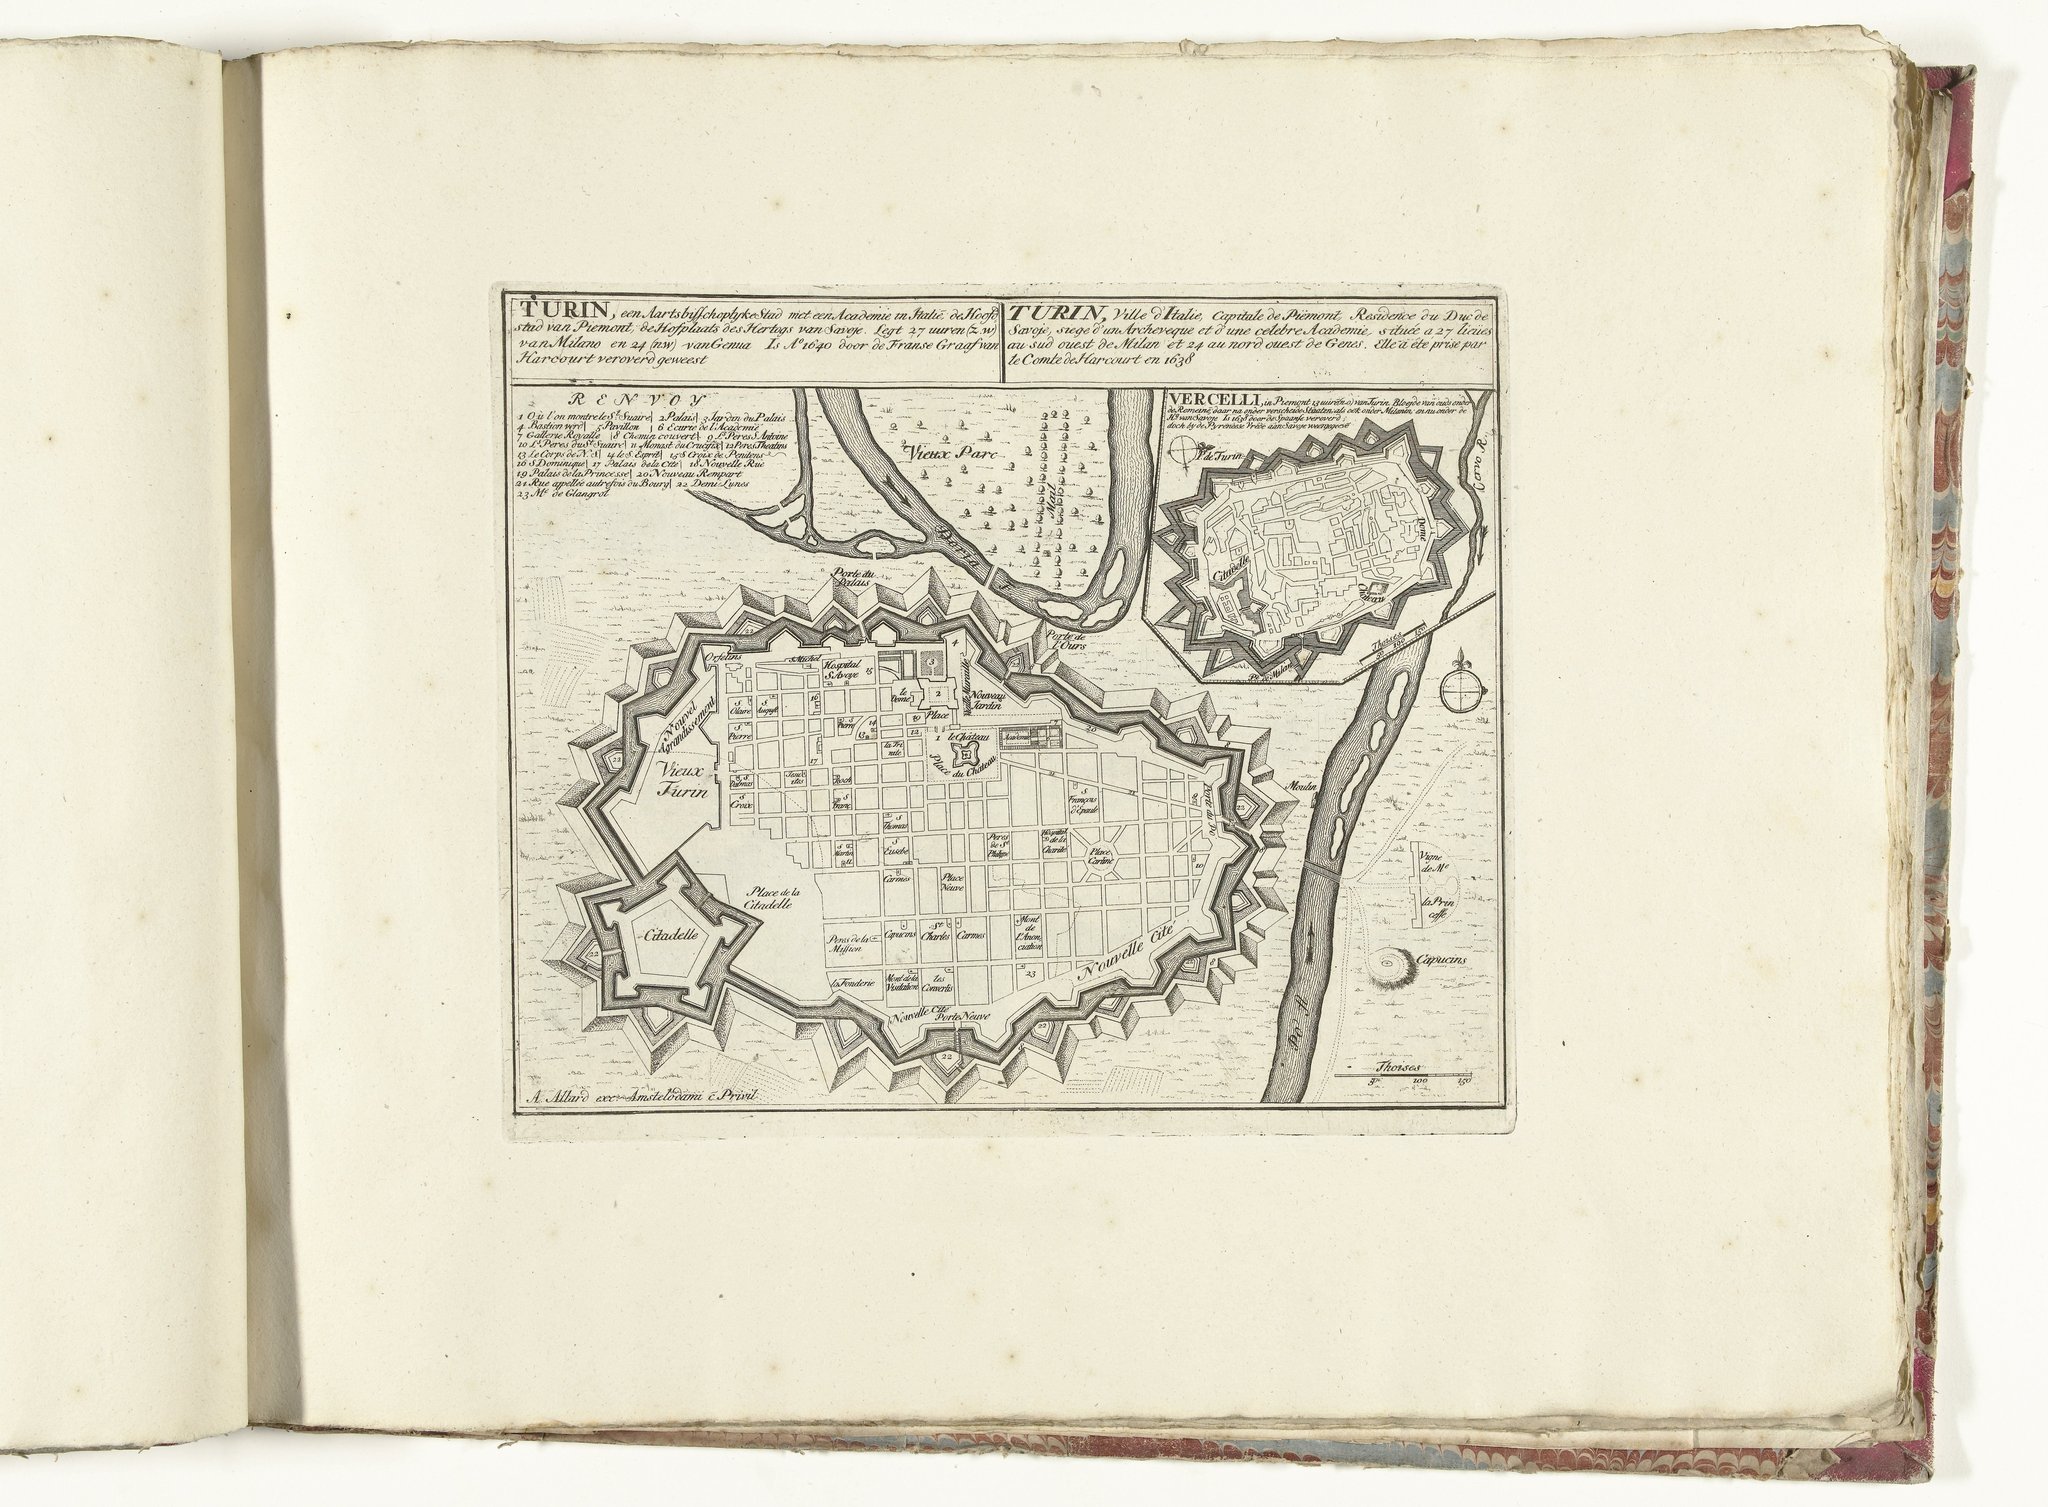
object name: map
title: Turin, een Aartsbisschoppelyke Stad met een Academie in Italie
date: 1701-1714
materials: paper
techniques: etching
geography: amsterdam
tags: maps of cities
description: Gekopieerd naar de Franse prenten in: Nicolas de Fer, Les forces de l'Europe, ou description des principales villes, avec leurs fortifications : dessignées par les meilleurs ingenieurs, particulierement celles ... de la France, dont les plans ont esté levez par M. de Vauban, Nicolas de Fer, Parijs 1693-1696, of andere voorbeelden.